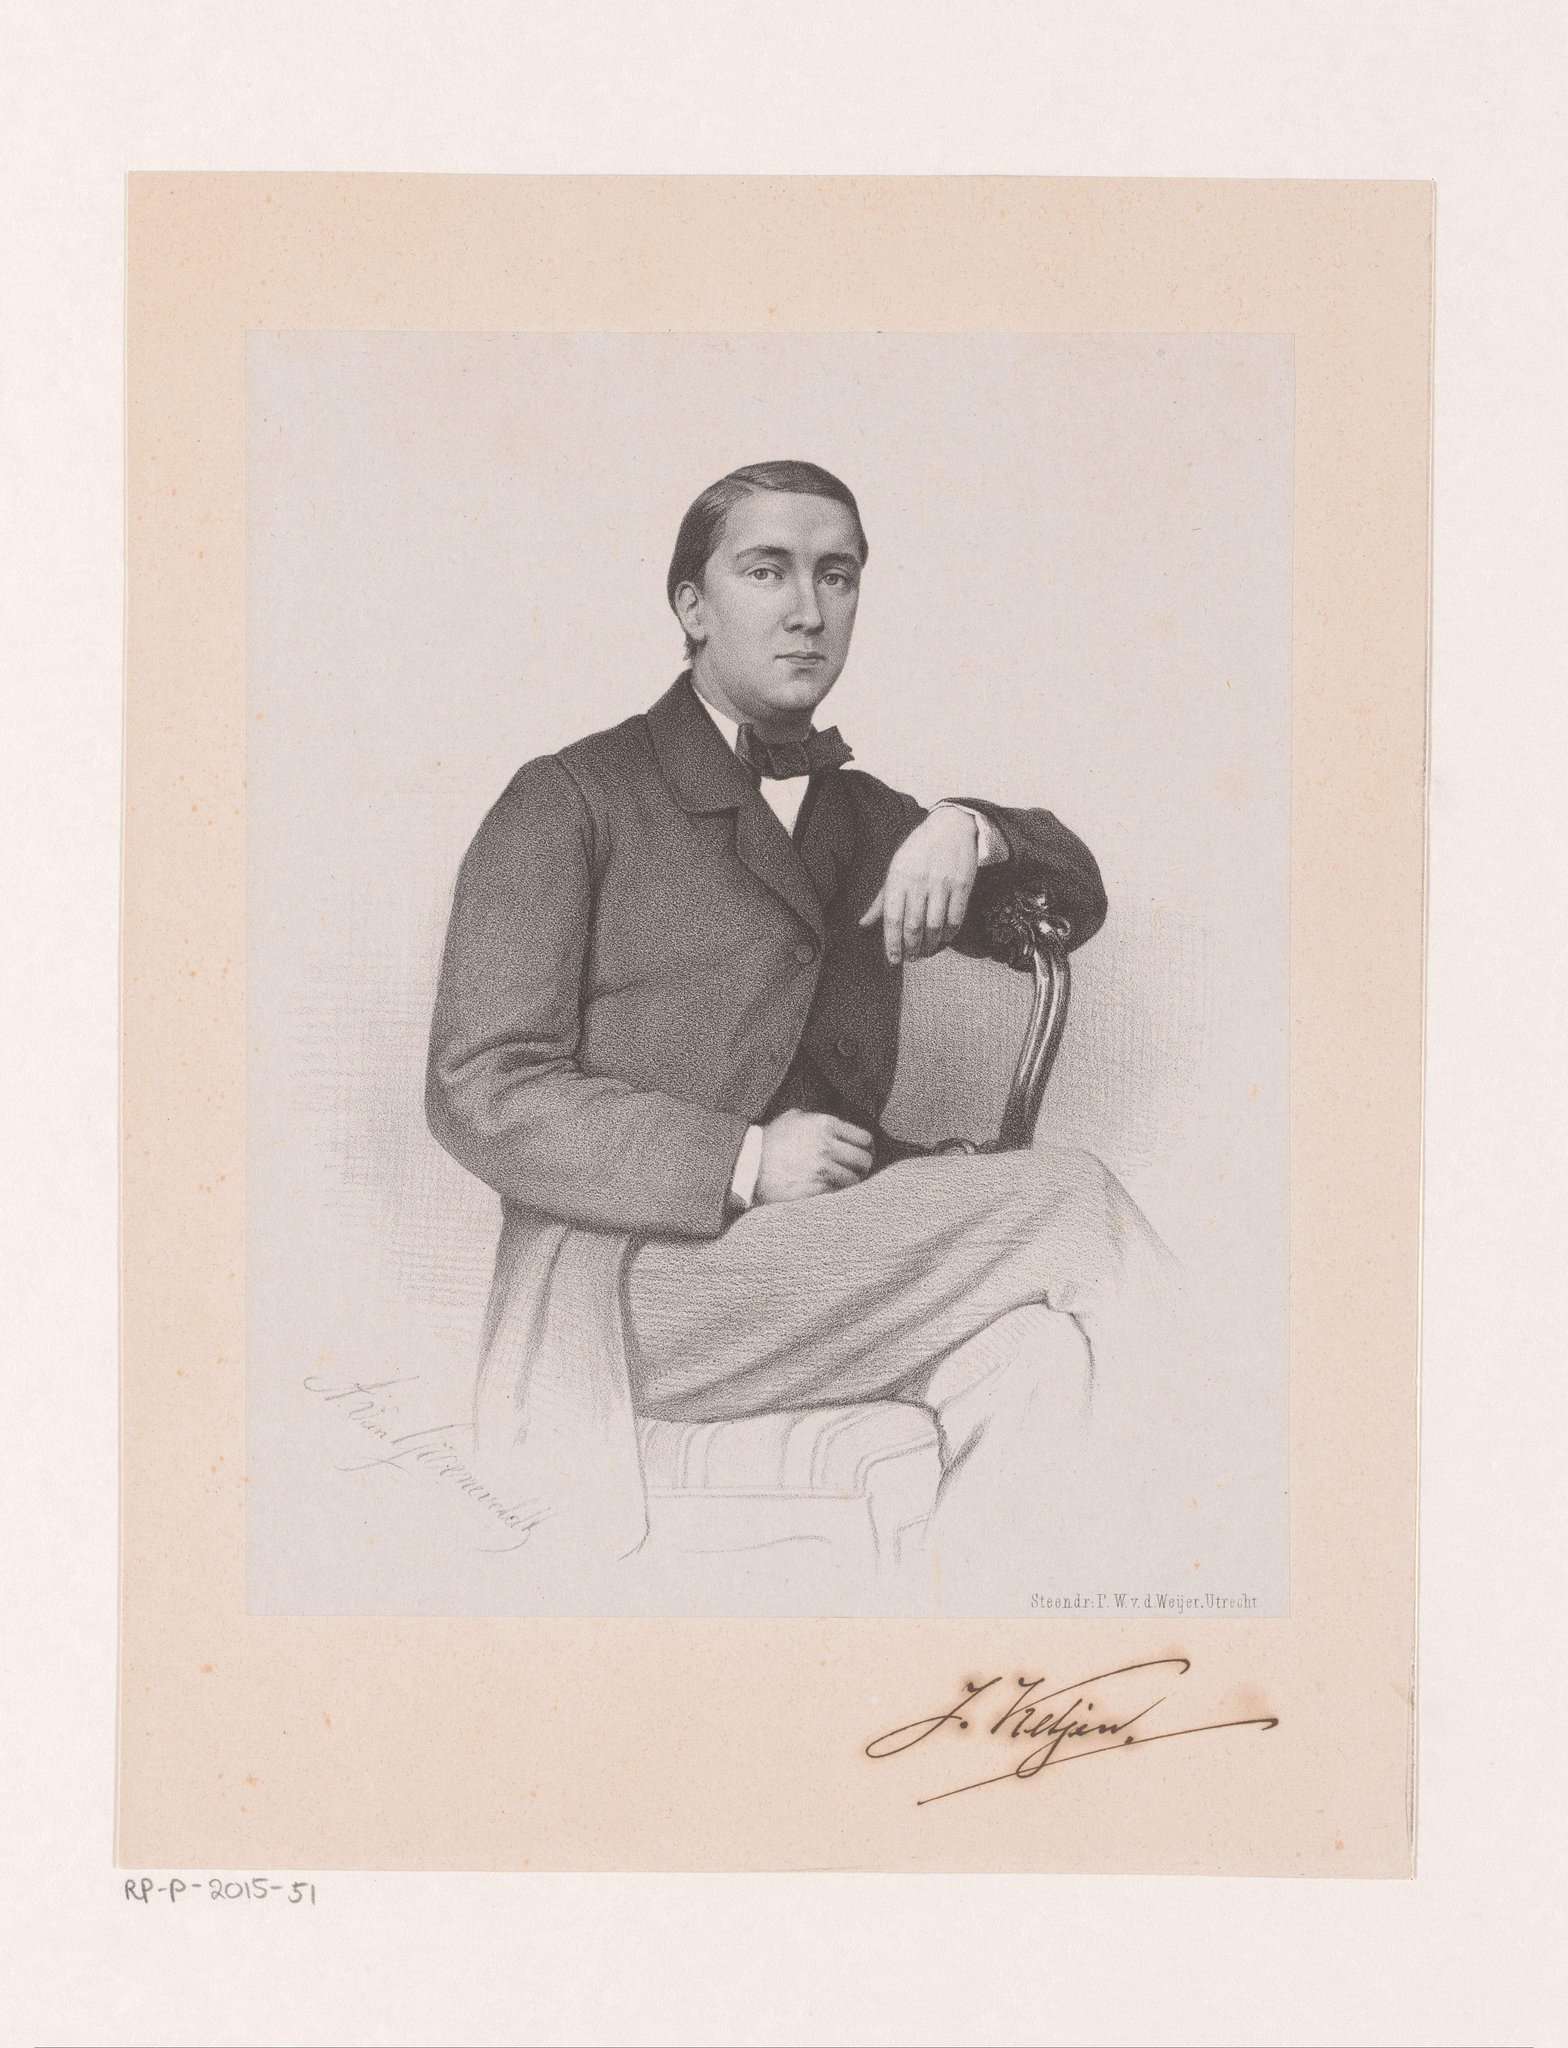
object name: print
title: Portret van een onbekende man, mogelijk J. Ketjen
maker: antonie johannes groeneveldt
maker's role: draughtsman, print maker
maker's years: 1824-1883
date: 1834-1883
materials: paper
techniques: lithograph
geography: utrecht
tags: historical persons (+ half-length portrait)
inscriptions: collector's mark: Lugt 2228, signature: ‘J. Ketjen.’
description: De geportretteerde zit schrijlings op een stoel.